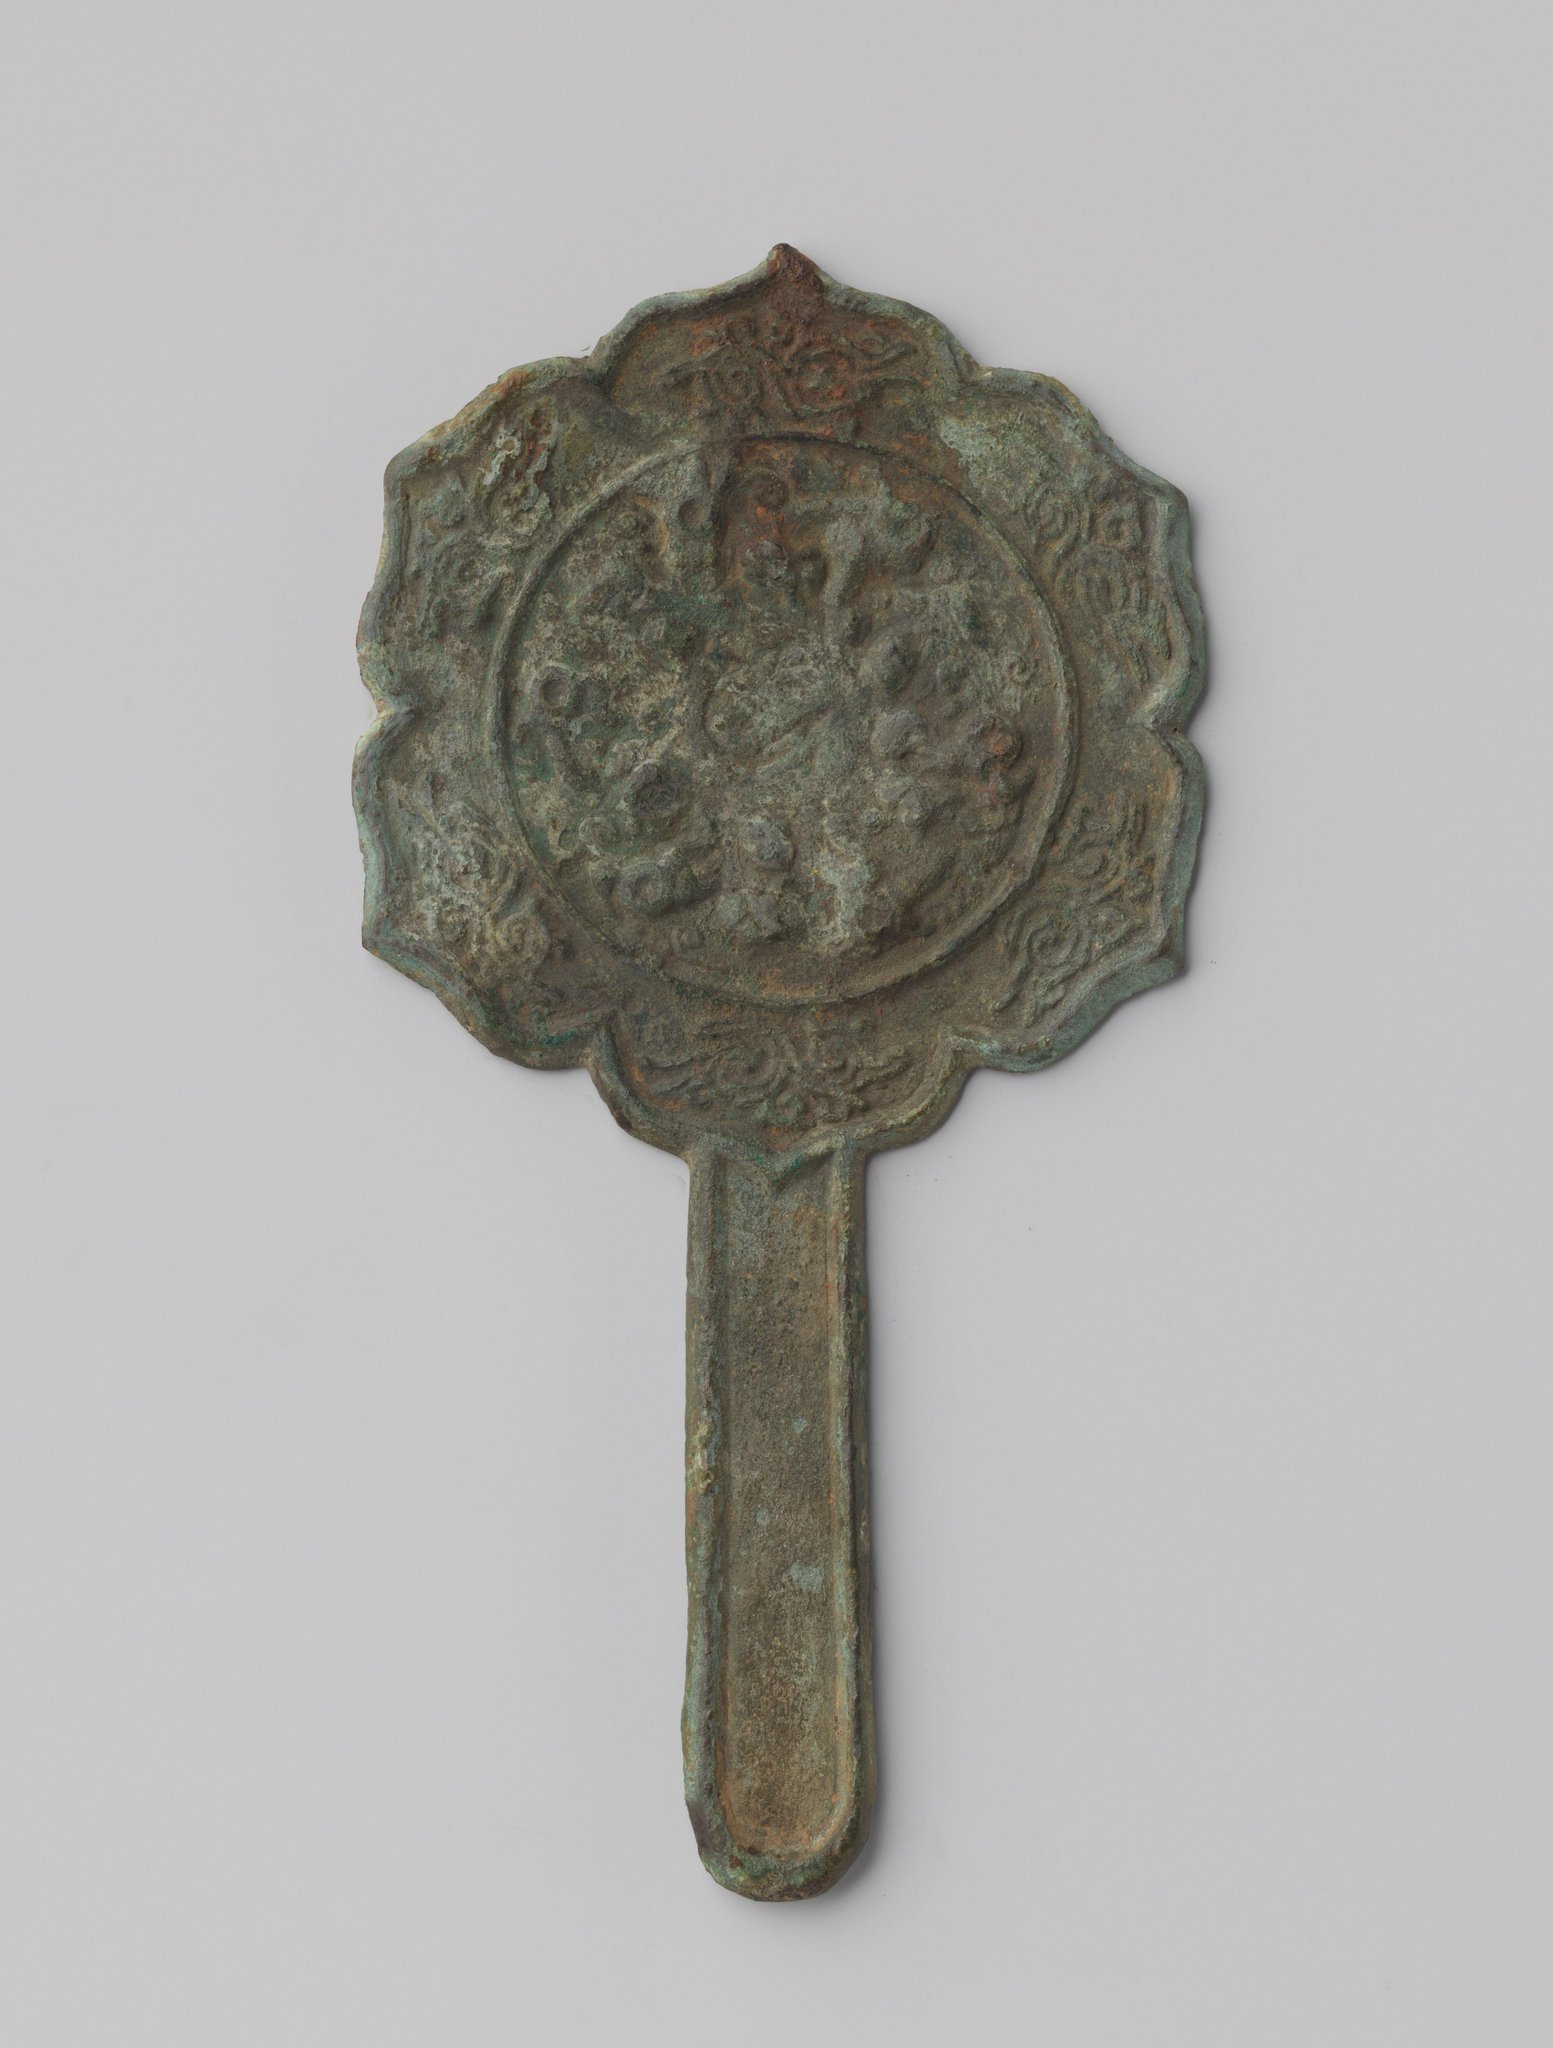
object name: mirror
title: Spiegel, zesmaal gelobde bladvorm, rand van plantenmotieven om rond medaillon, voorzien van plat handvat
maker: Anonymous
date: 900-1200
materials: bronze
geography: china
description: Mirror. China. Song period (960 - 1279). Bronze Mirrors with handles were rare in China. During the Song period, however, they were more frequently made. Scaly leaves along the edge is a typical Song motif. Given by H.J.H. Nauta.